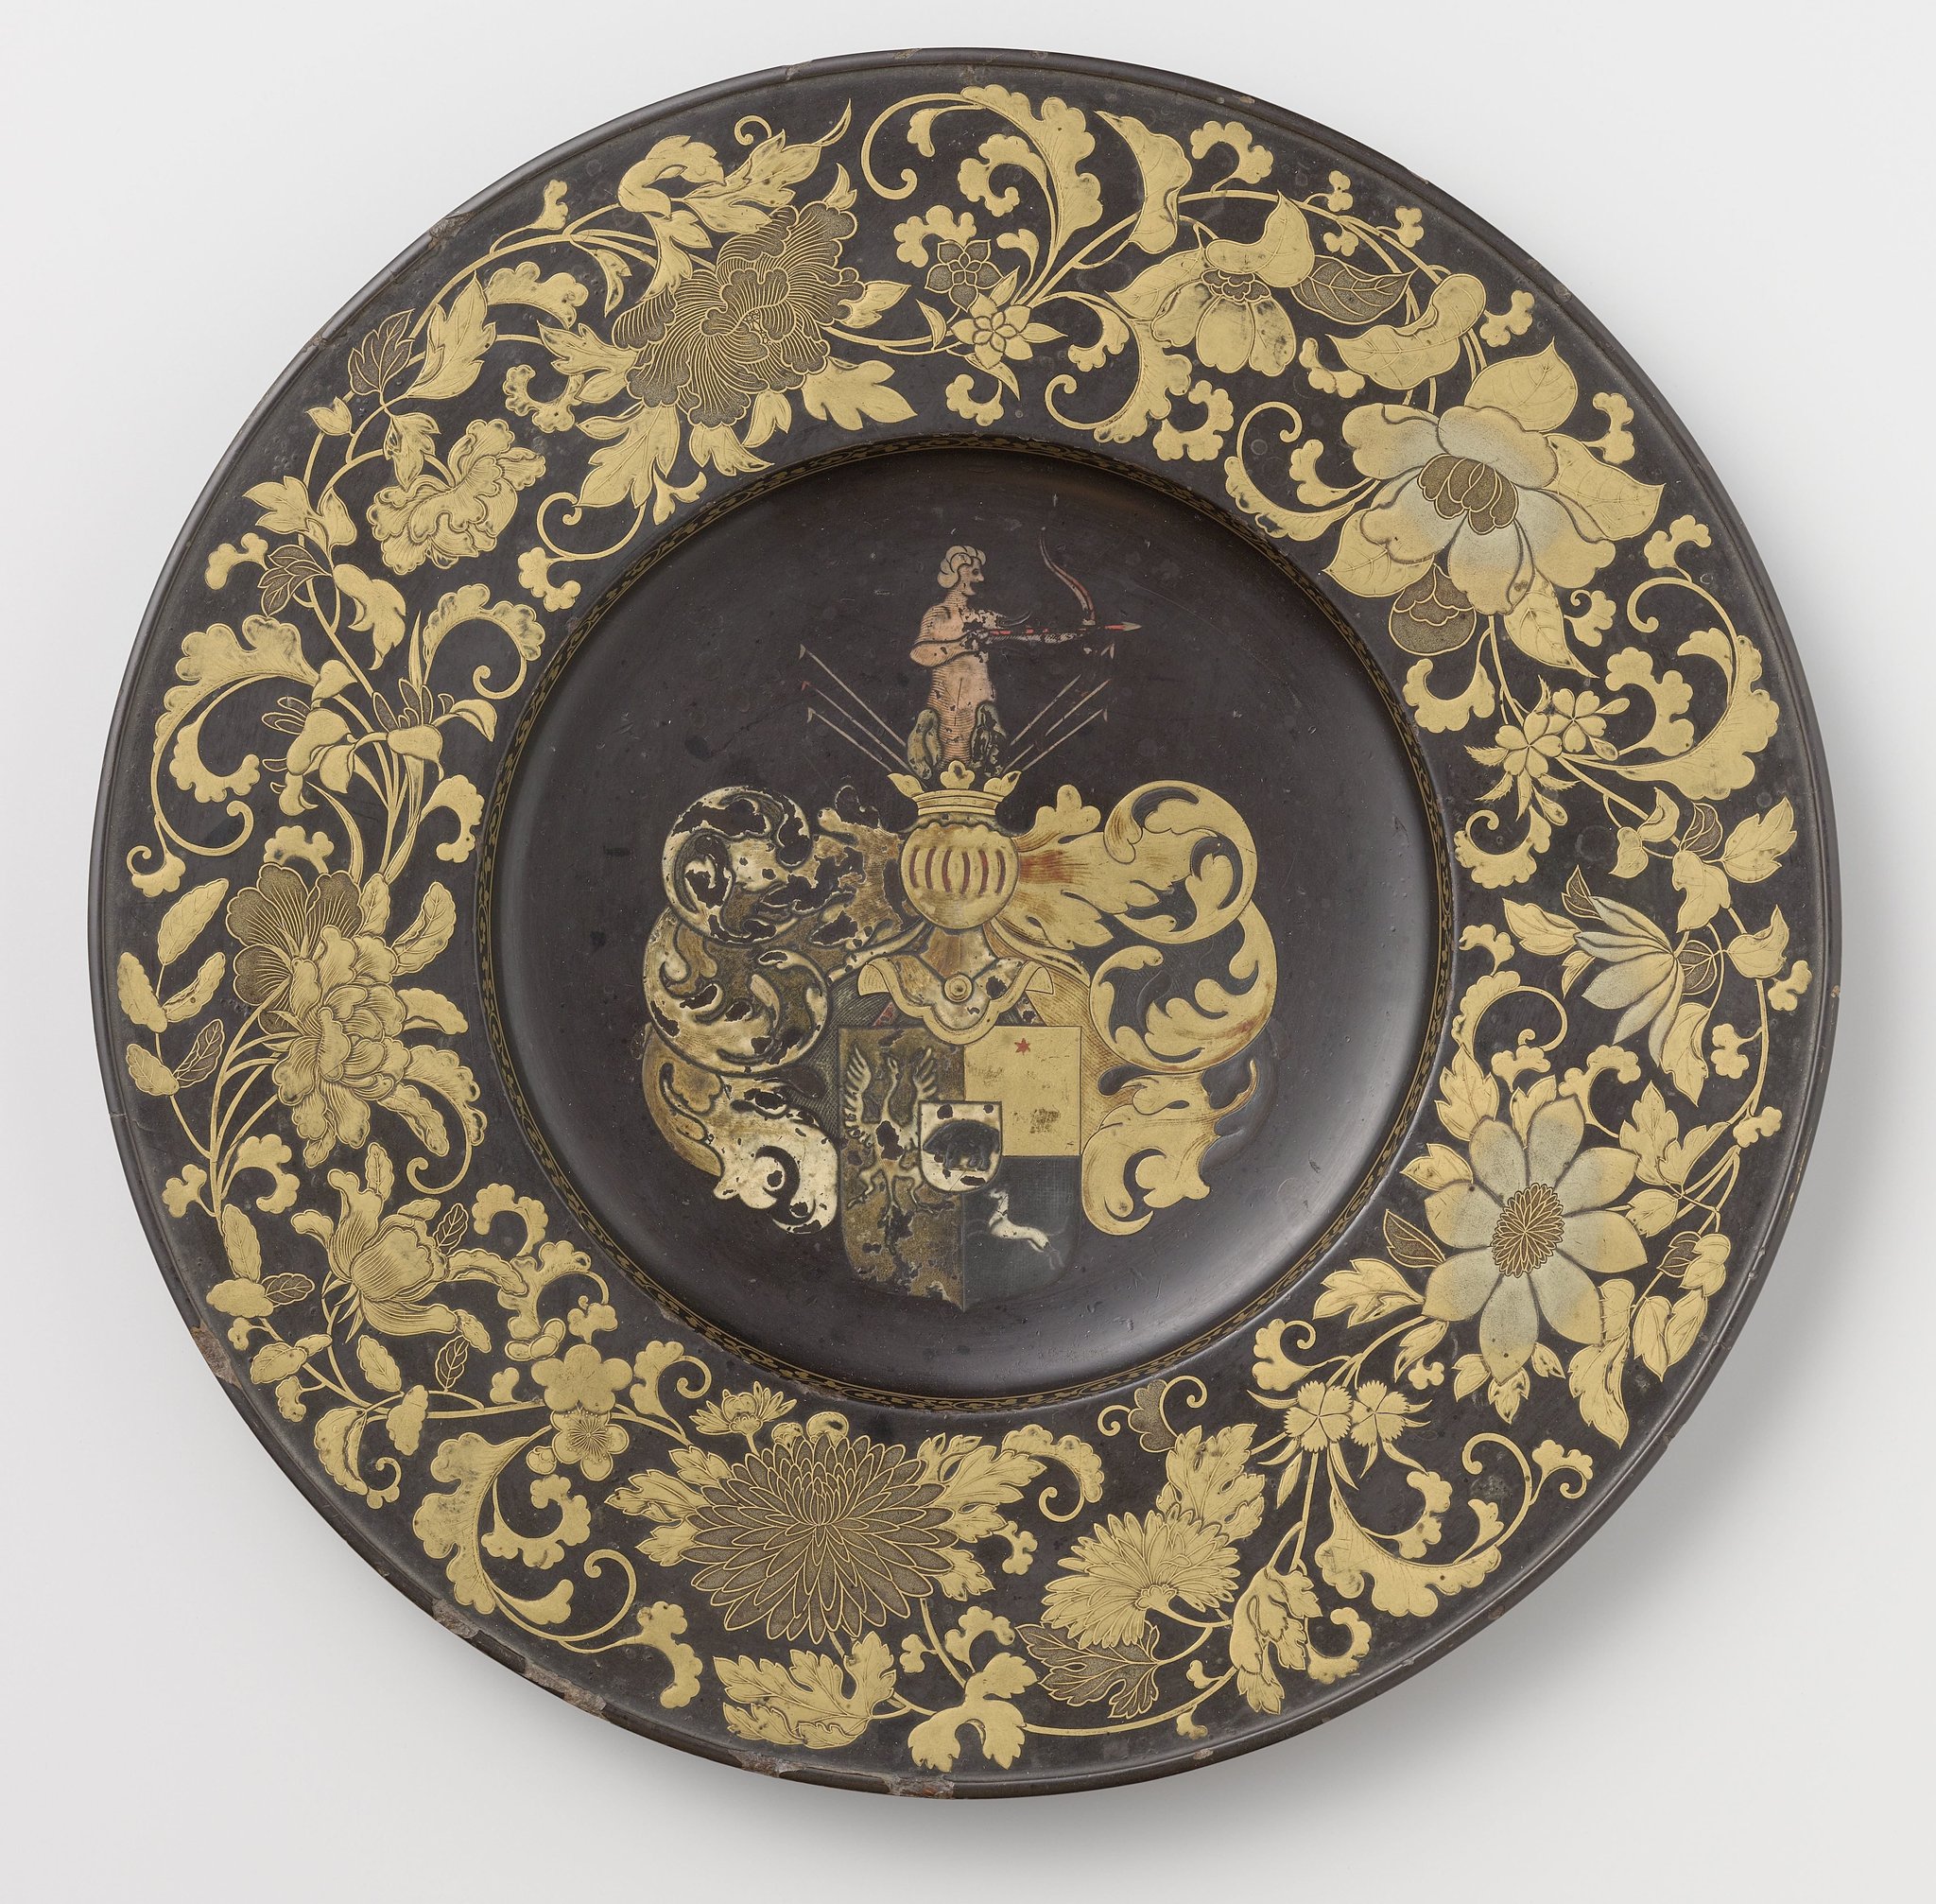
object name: wandbord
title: Decorative Dish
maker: Anonymous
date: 1650-1660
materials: lacquer, wood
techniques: gilding, lacquer, turning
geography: japan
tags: amsterdam, mayor, joan huydecoper van maarseveen (i)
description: Lacquerware was a prized luxury product, with its rich gold decorations on a dark black background. This decorative dish was a special order as it bears the coat-of-arms of Joan van Huydecoper van Maarsseveen. In addition to being burgomaster of Amsterdam, he was director of the VOC, and so had the right connections to order lacquerware in Japan.